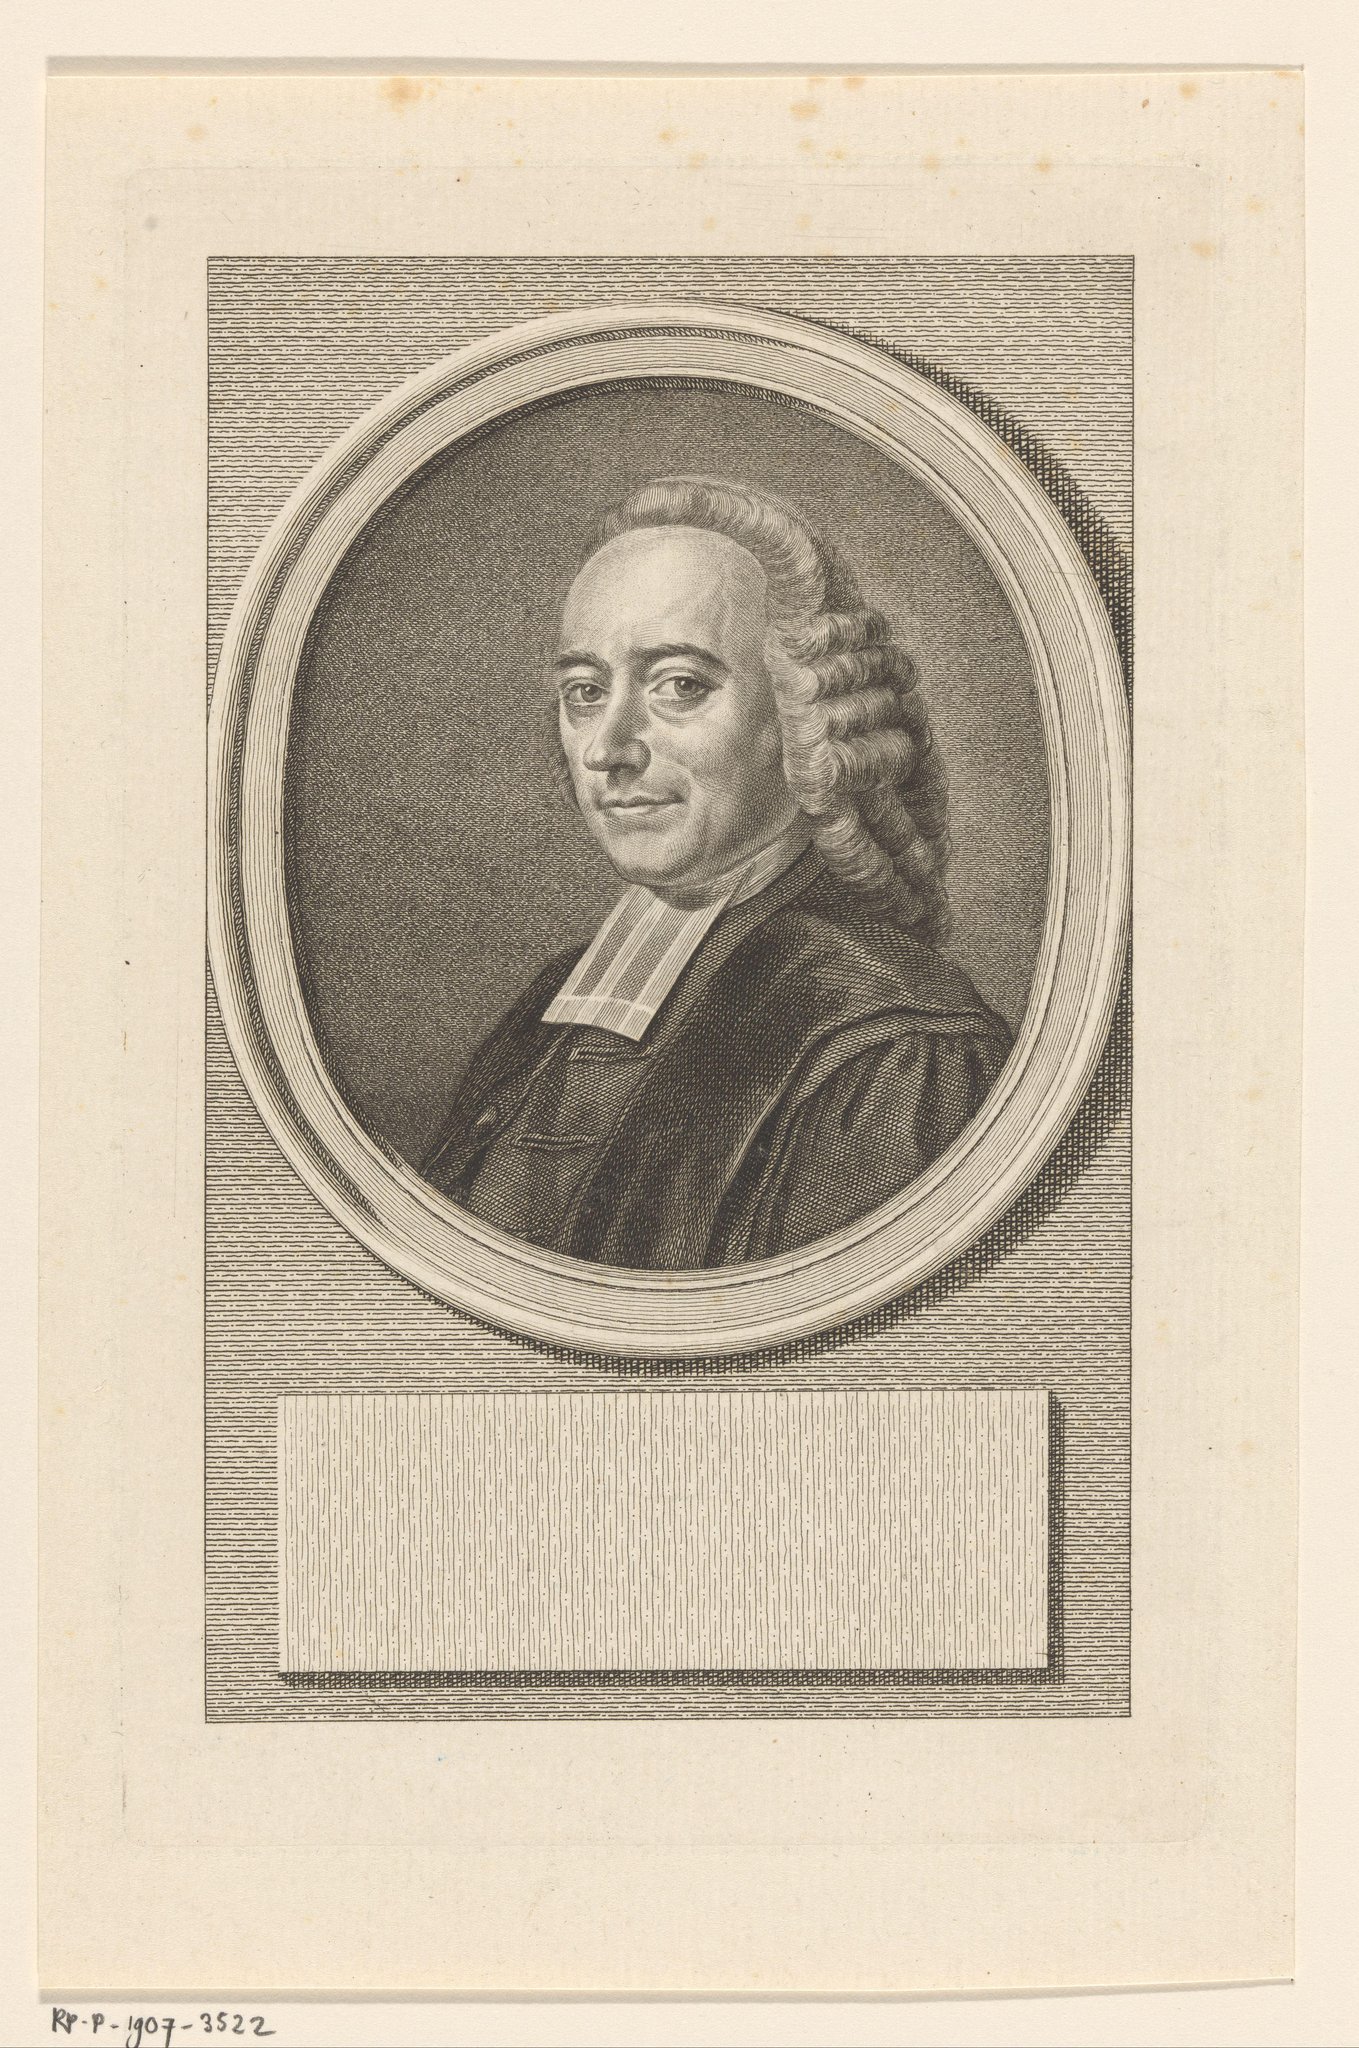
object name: print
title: Portret van Gerard Johan Nahuys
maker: reinier vinkeles (i)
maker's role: draughtsman, print maker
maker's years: 1741-1816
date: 1781-1816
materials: paper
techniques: engraving, etching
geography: amsterdam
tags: utrecht, leiden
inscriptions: collector's mark: Lugt 2228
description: Portret van Gerard Johan Nahuys, predikant te Leiden.